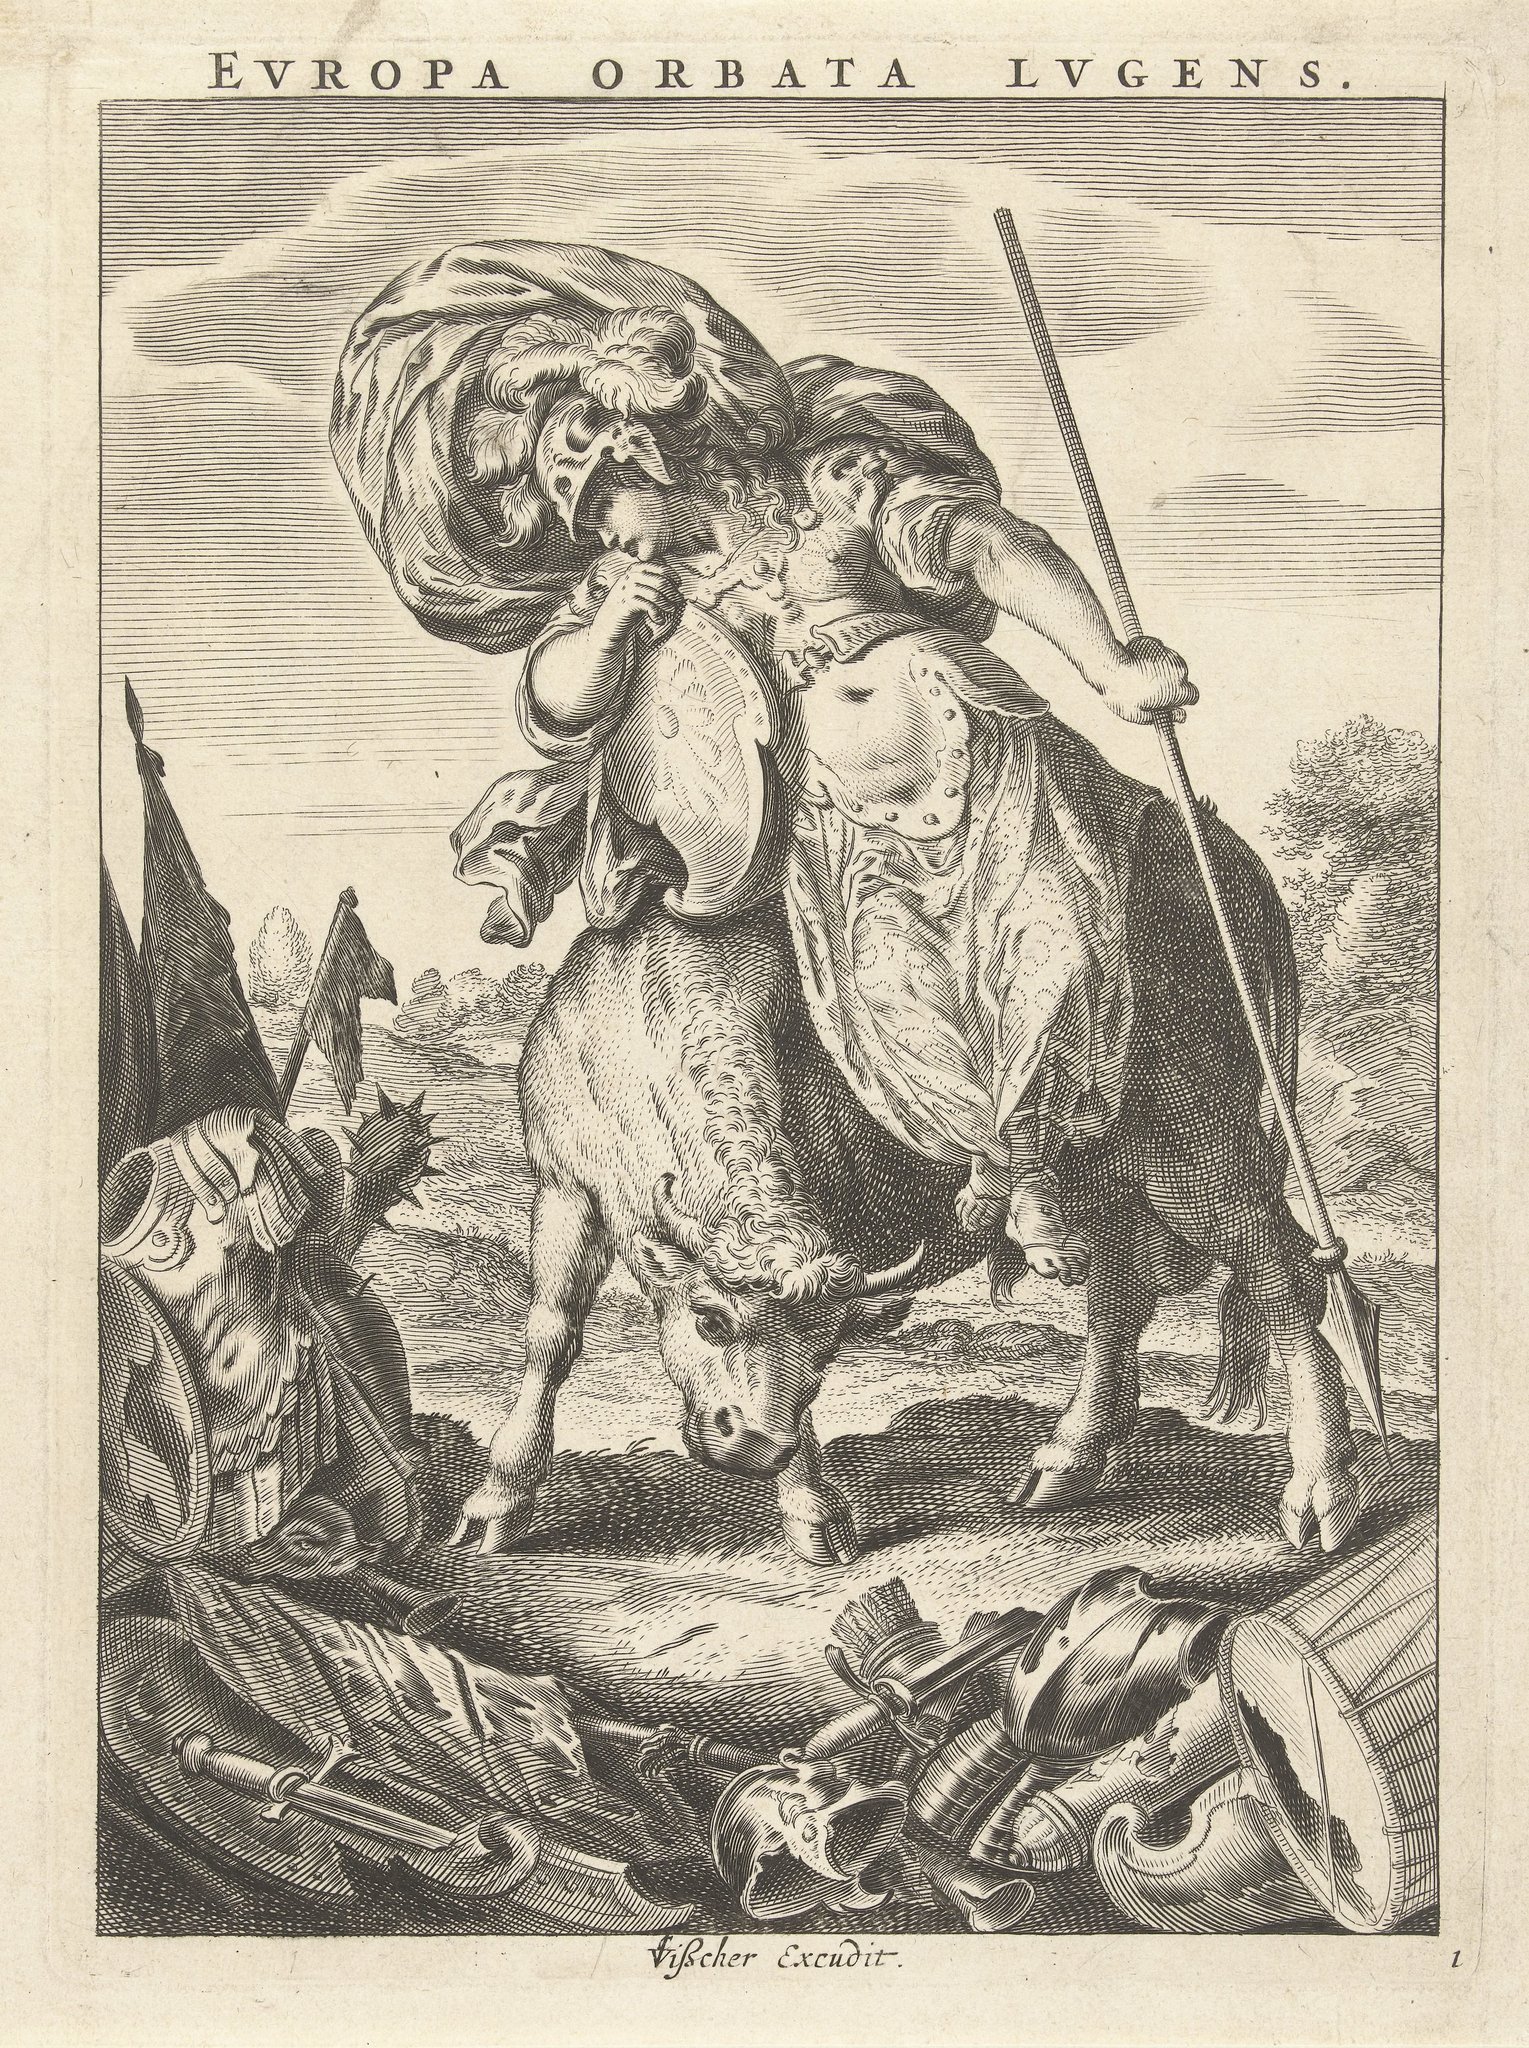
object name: print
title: Vier werelddelen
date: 1648-1664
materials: paper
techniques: engraving, etching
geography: amsterdam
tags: jupiter, usually in the shape of a white bull, abducts europa and carries her across the water, bull, europe represented allegorically; 'europa' (ripa)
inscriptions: collector's mark: Lugt 2228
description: Vrouwelijke personificatie van werelddeel Europa voorgesteld als vrouw in wapenrusting zittend op stier, een verwijzing naar de mythologische Europa die ontvoerd werd door Jupiter in de gedaante van een stier. Op de voorgrond ligt oorlogsbuit. De vrouw leunt treurend op haar schild, zij betreurt de berovingen aldus de titel.